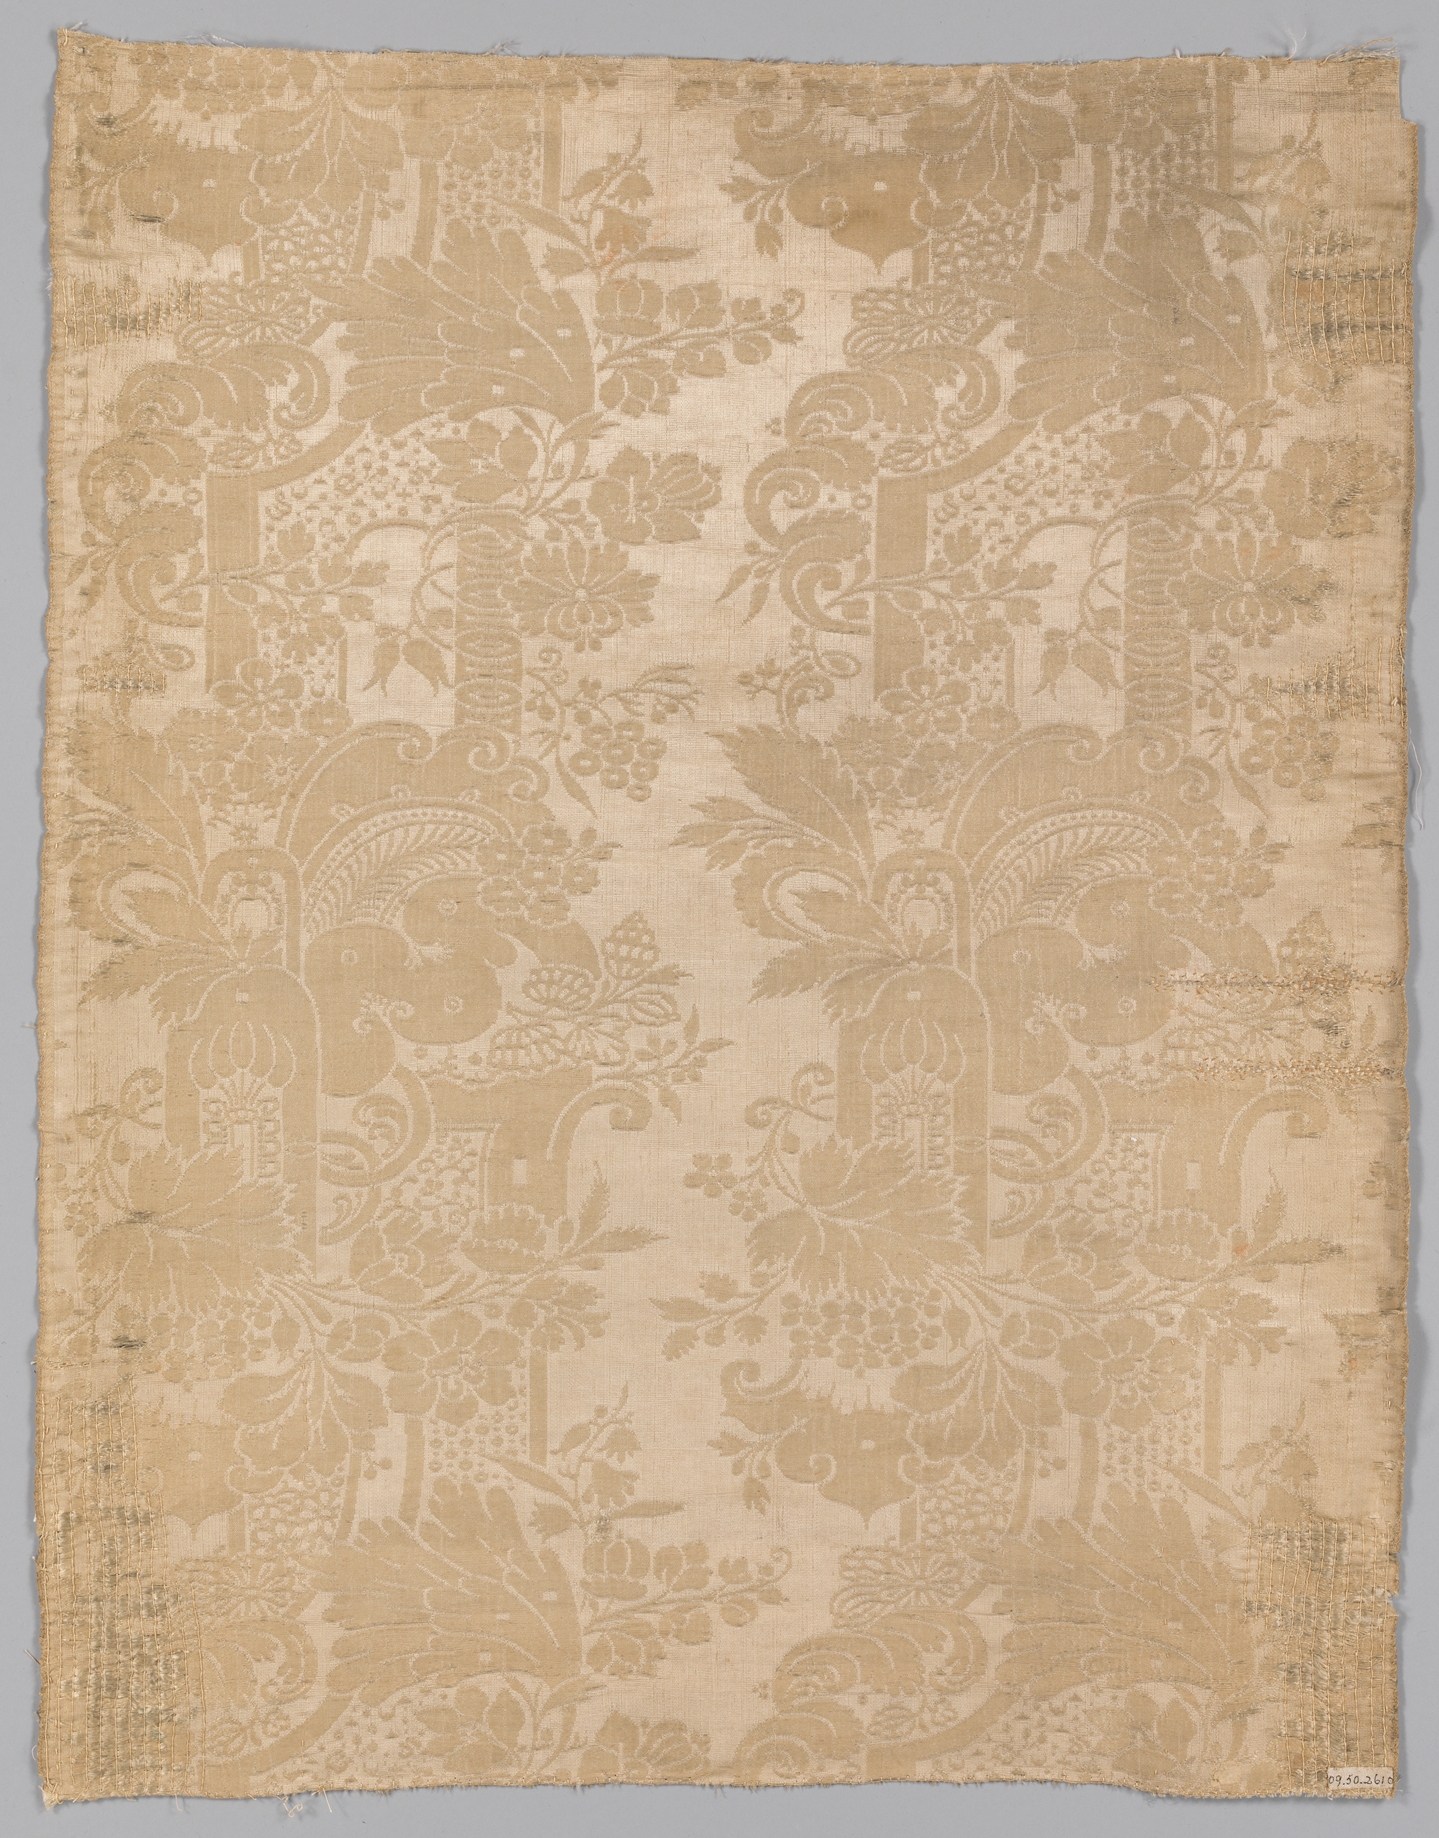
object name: piece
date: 1726-1750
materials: silk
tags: leaves